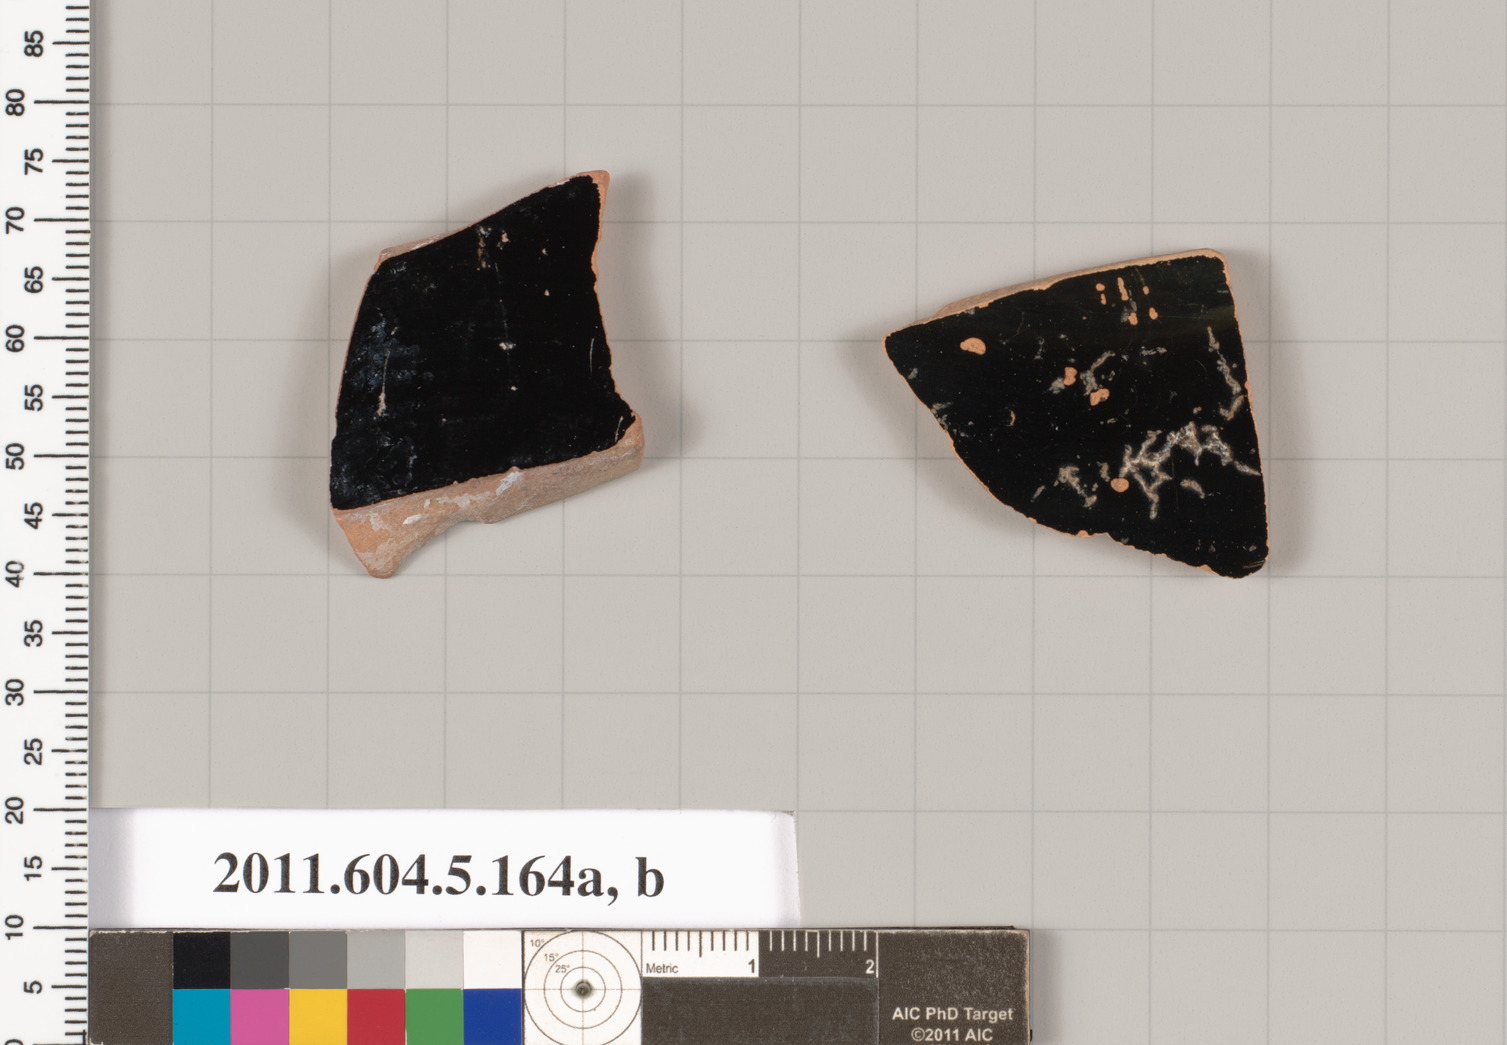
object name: kylix fragment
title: Terracotta fragments of kylikes (drinking cups)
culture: greek, attic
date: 600-401 BCE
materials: terracotta